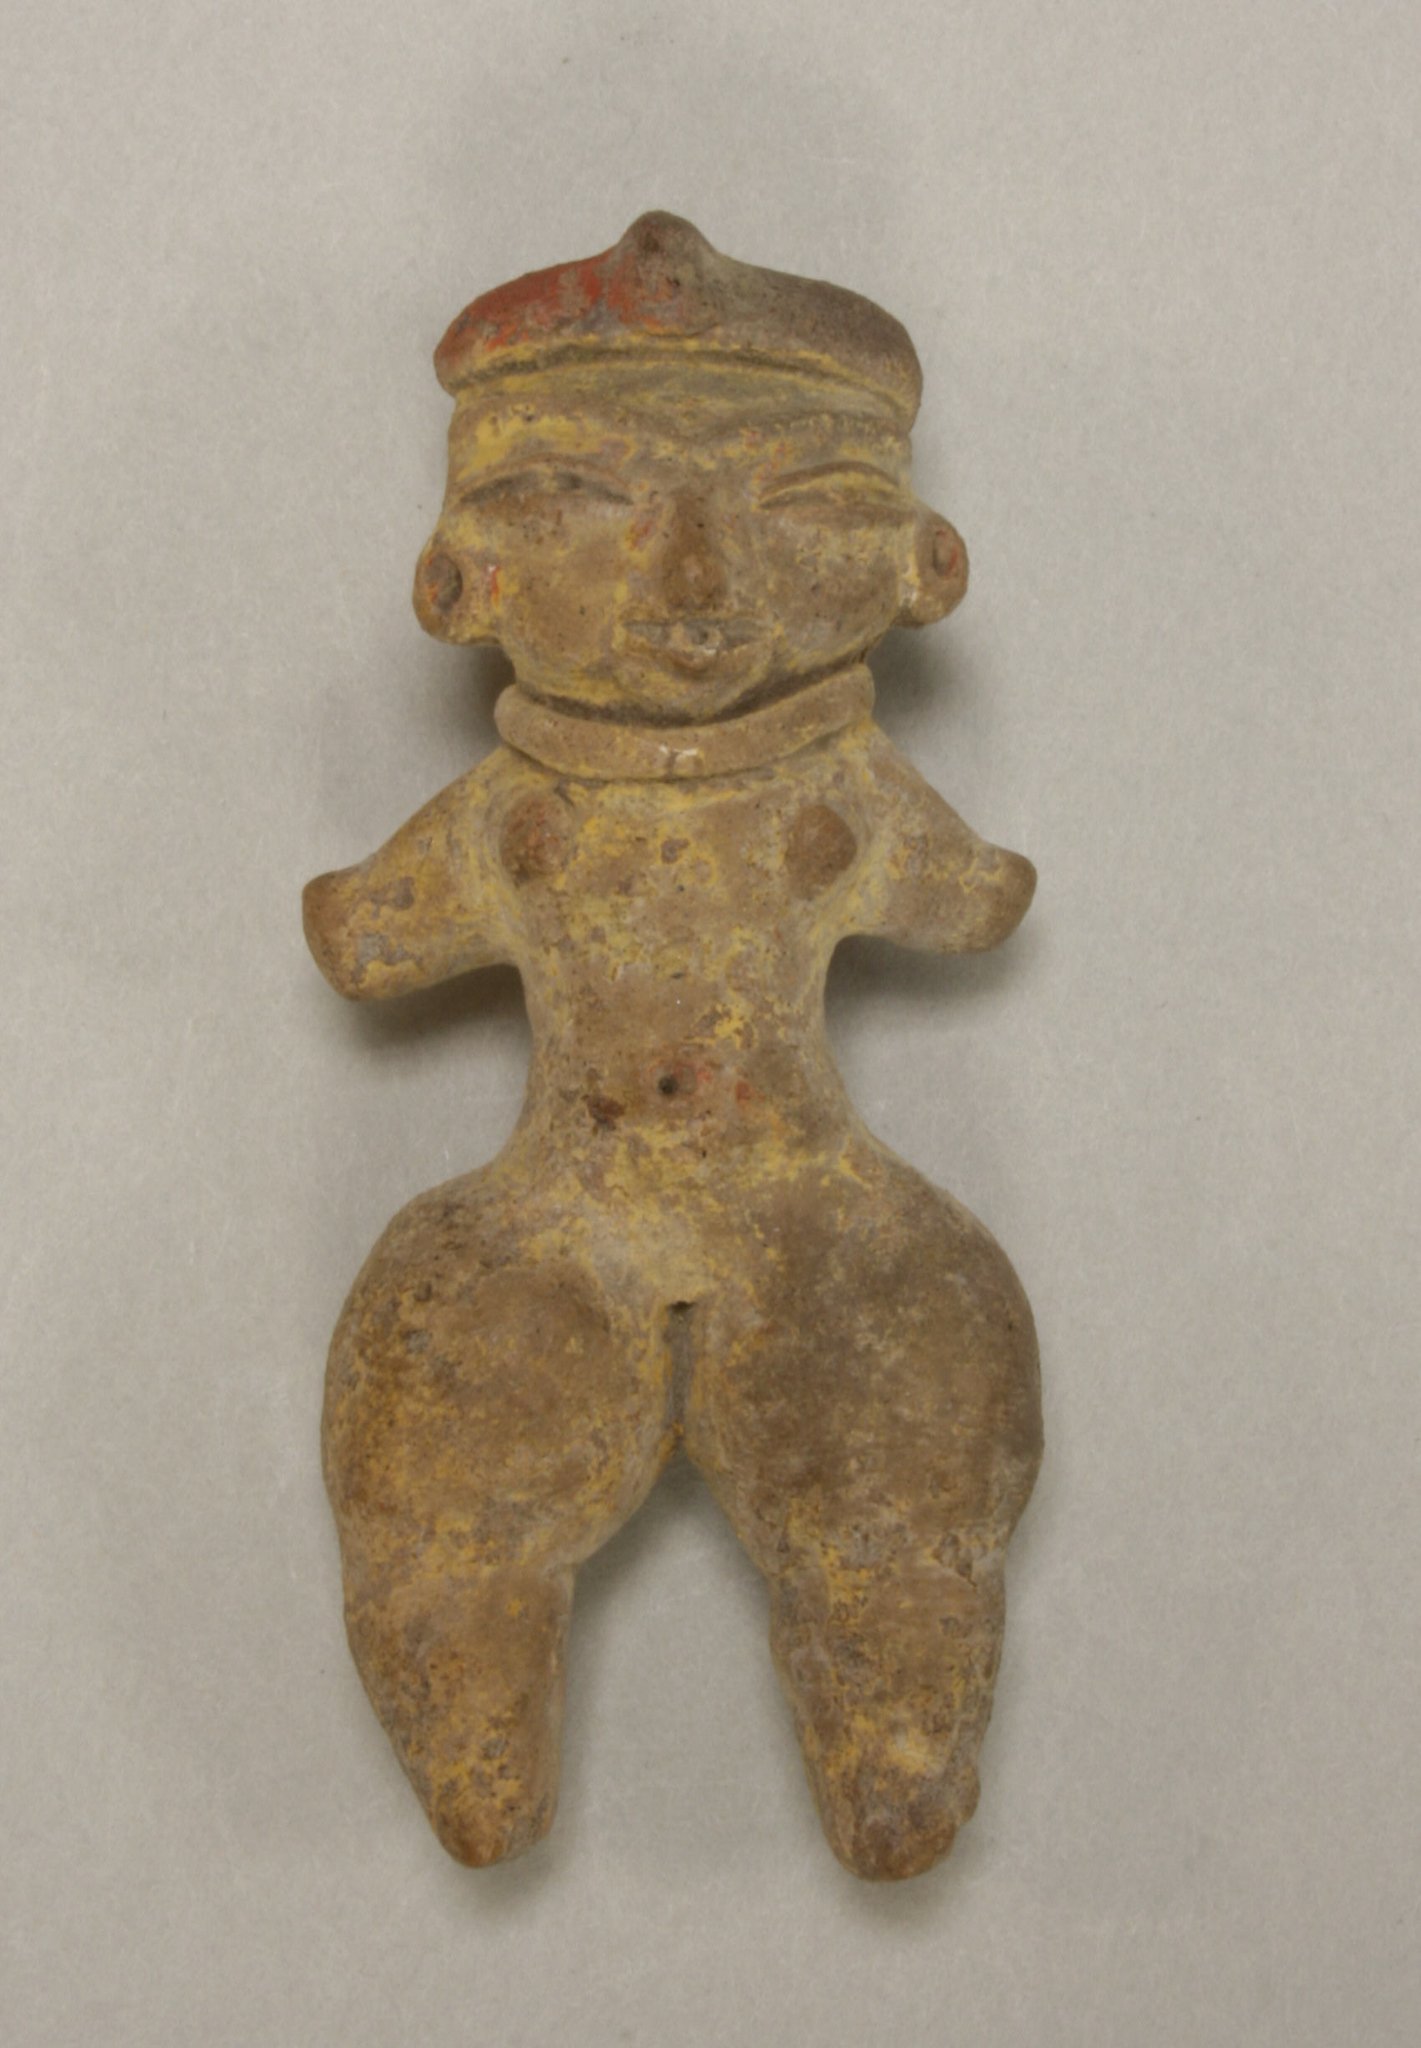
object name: female figure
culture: tlatilco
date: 1200-801 BCE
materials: ceramic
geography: mexico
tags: women